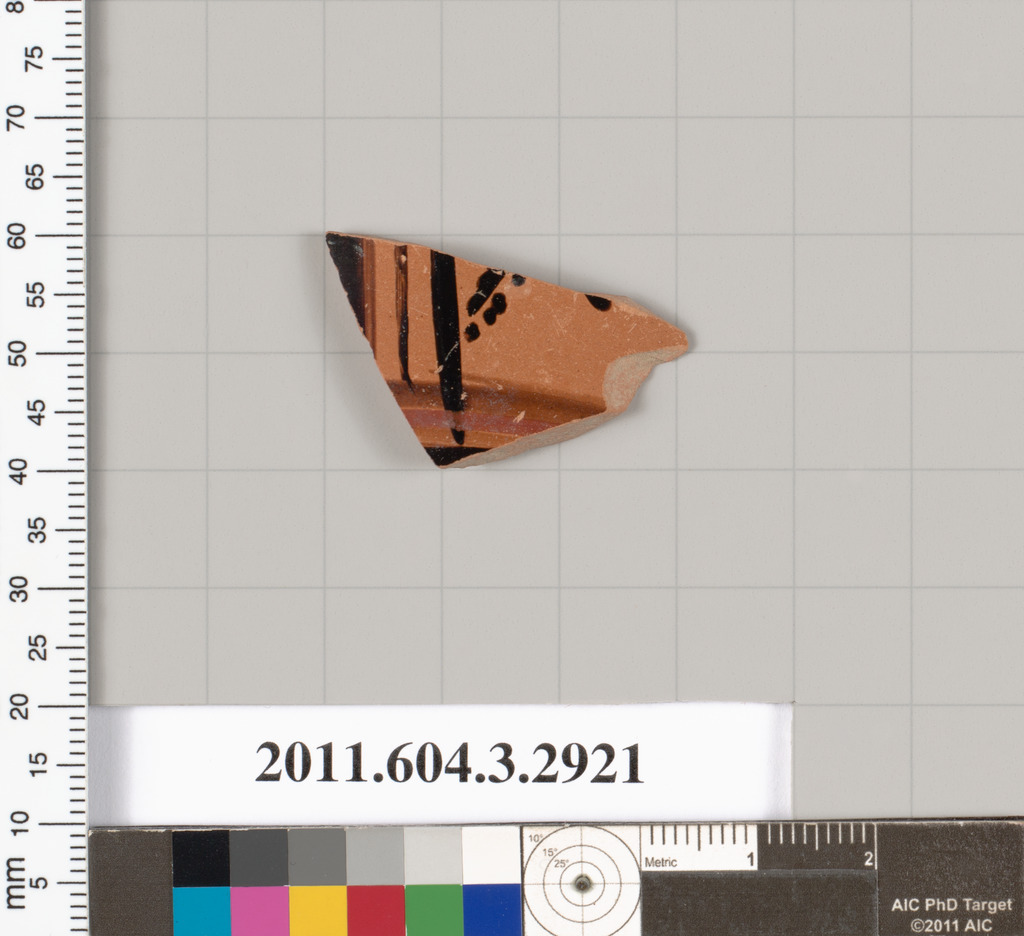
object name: oinochoe or olpe fragment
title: Terracotta fragment of an oinochoe (jug) or an olpe (jug)?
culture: greek, attic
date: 534-501 BCE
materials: terracotta